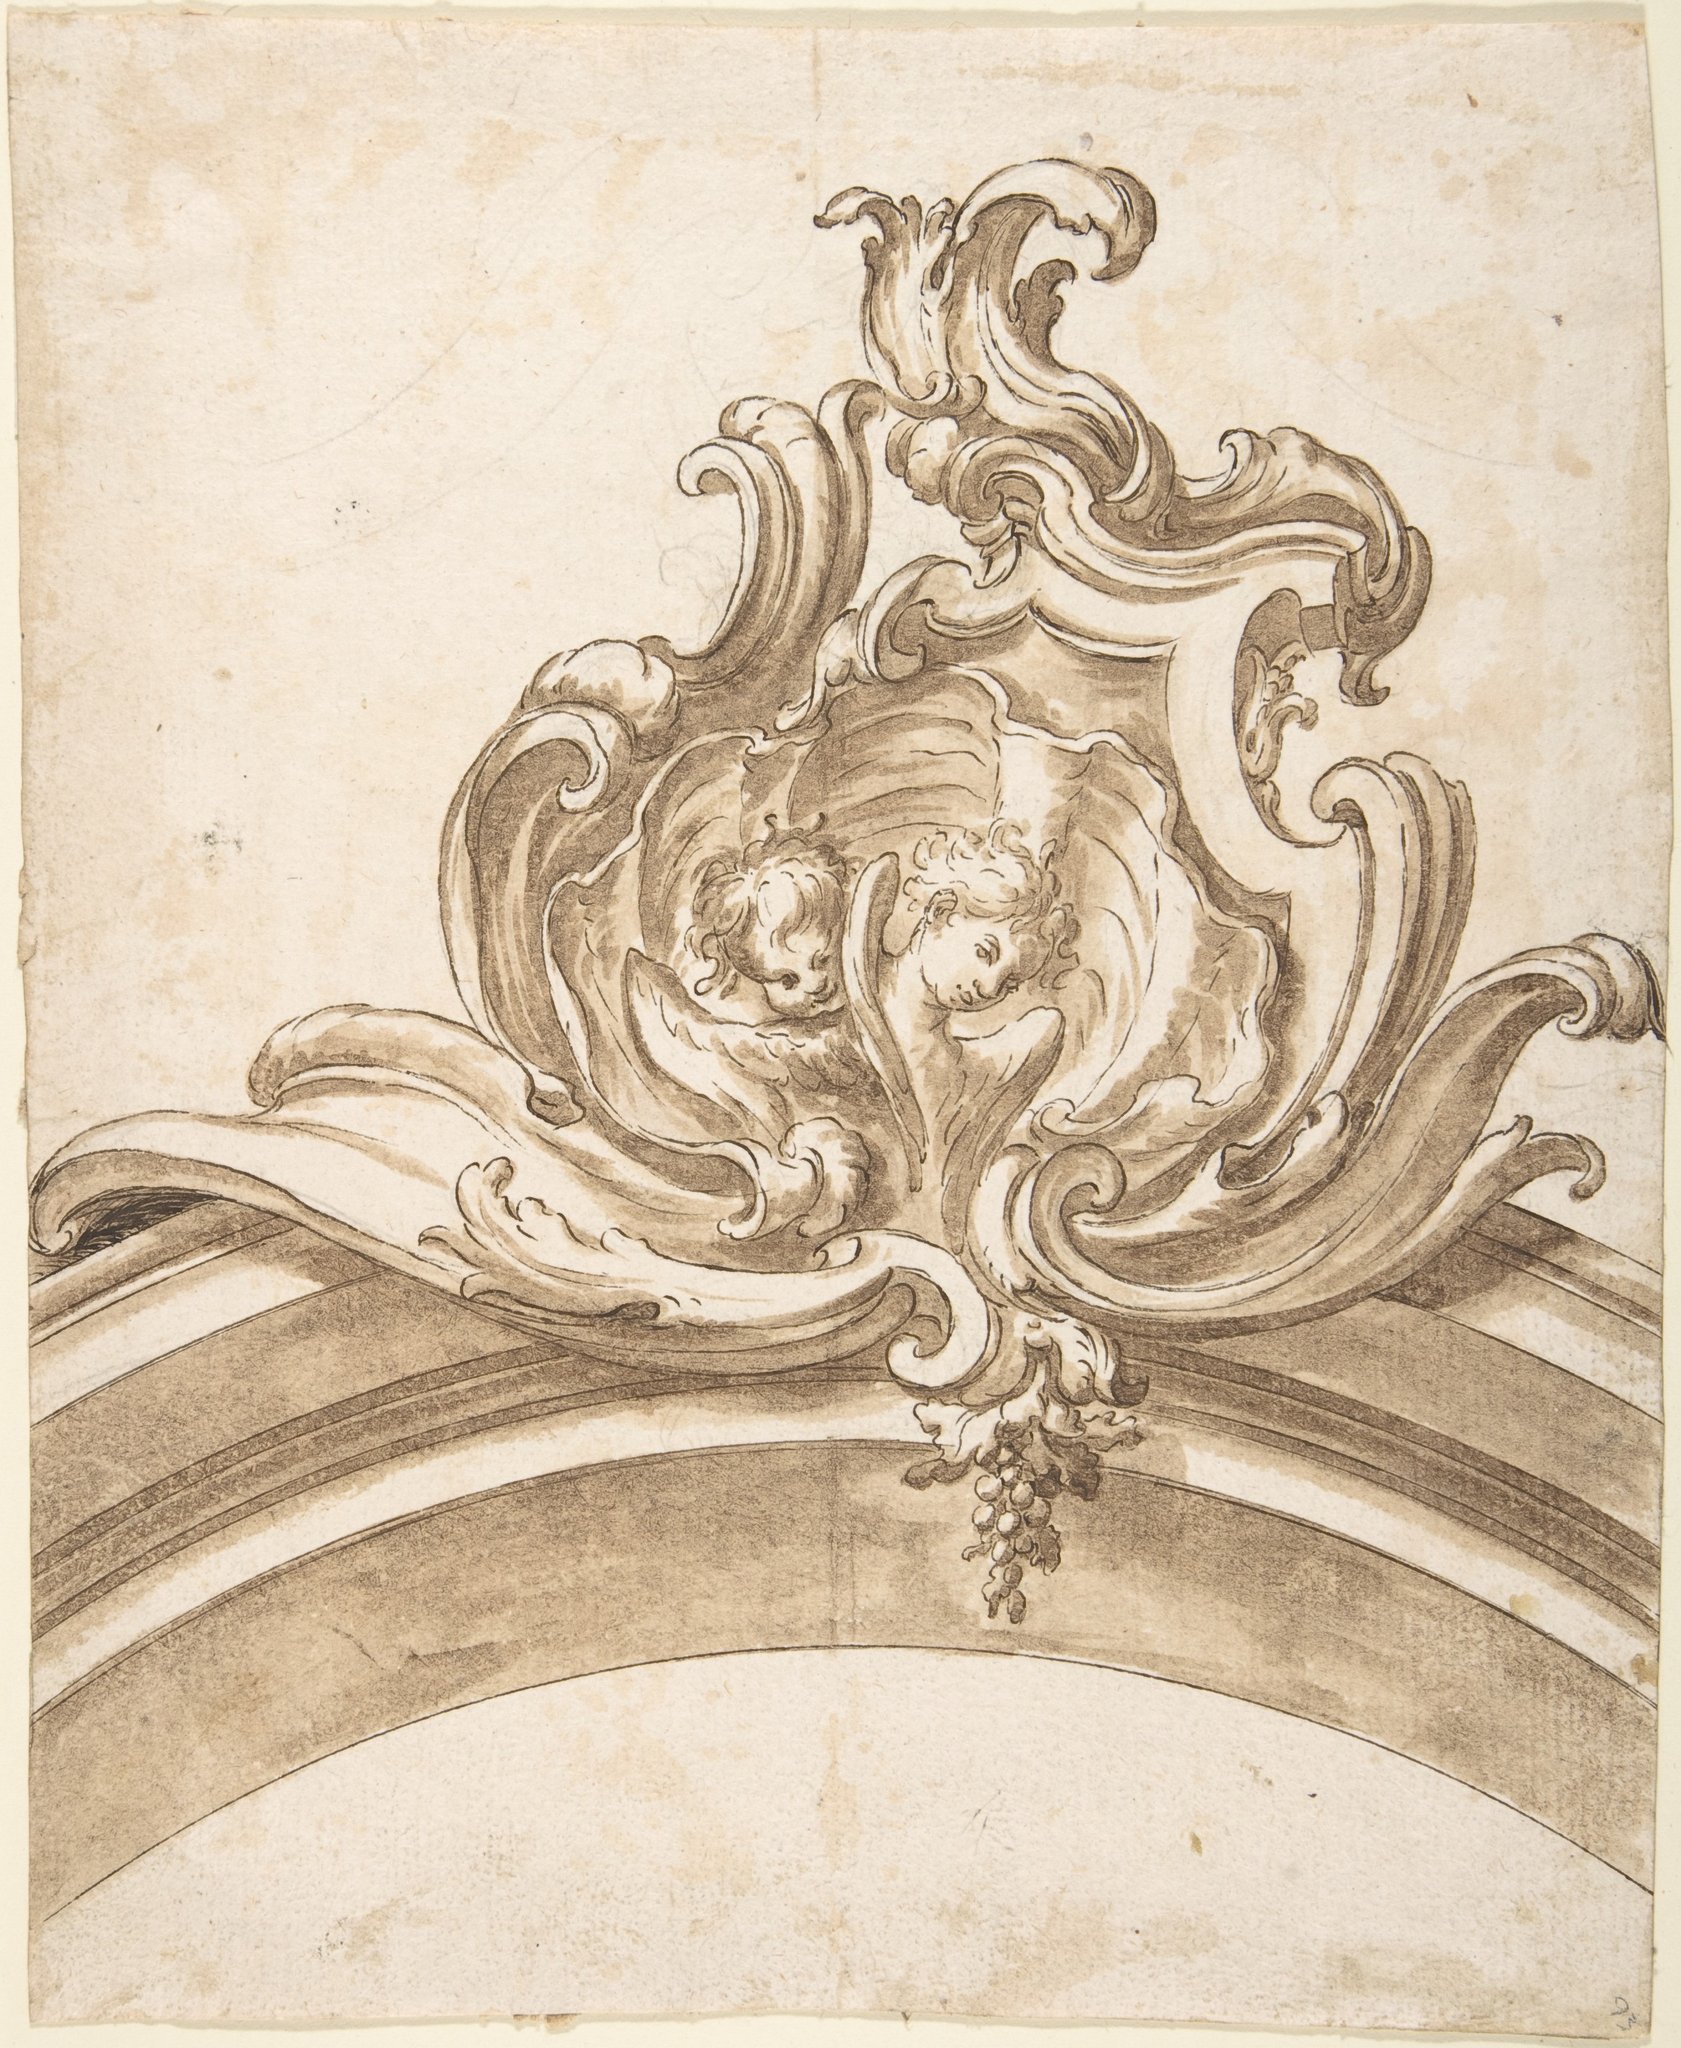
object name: drawing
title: Design for a Cartouche with Two Putti Heads inside a Shell, Atop an Arch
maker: anonymous, italian, piedmontese, 18th century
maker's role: artist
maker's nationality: italian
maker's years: 1700-1800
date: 1700-1780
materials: chalk, graphite, ink, drawing material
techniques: brush, pen, wash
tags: cartouches,ornament,putti